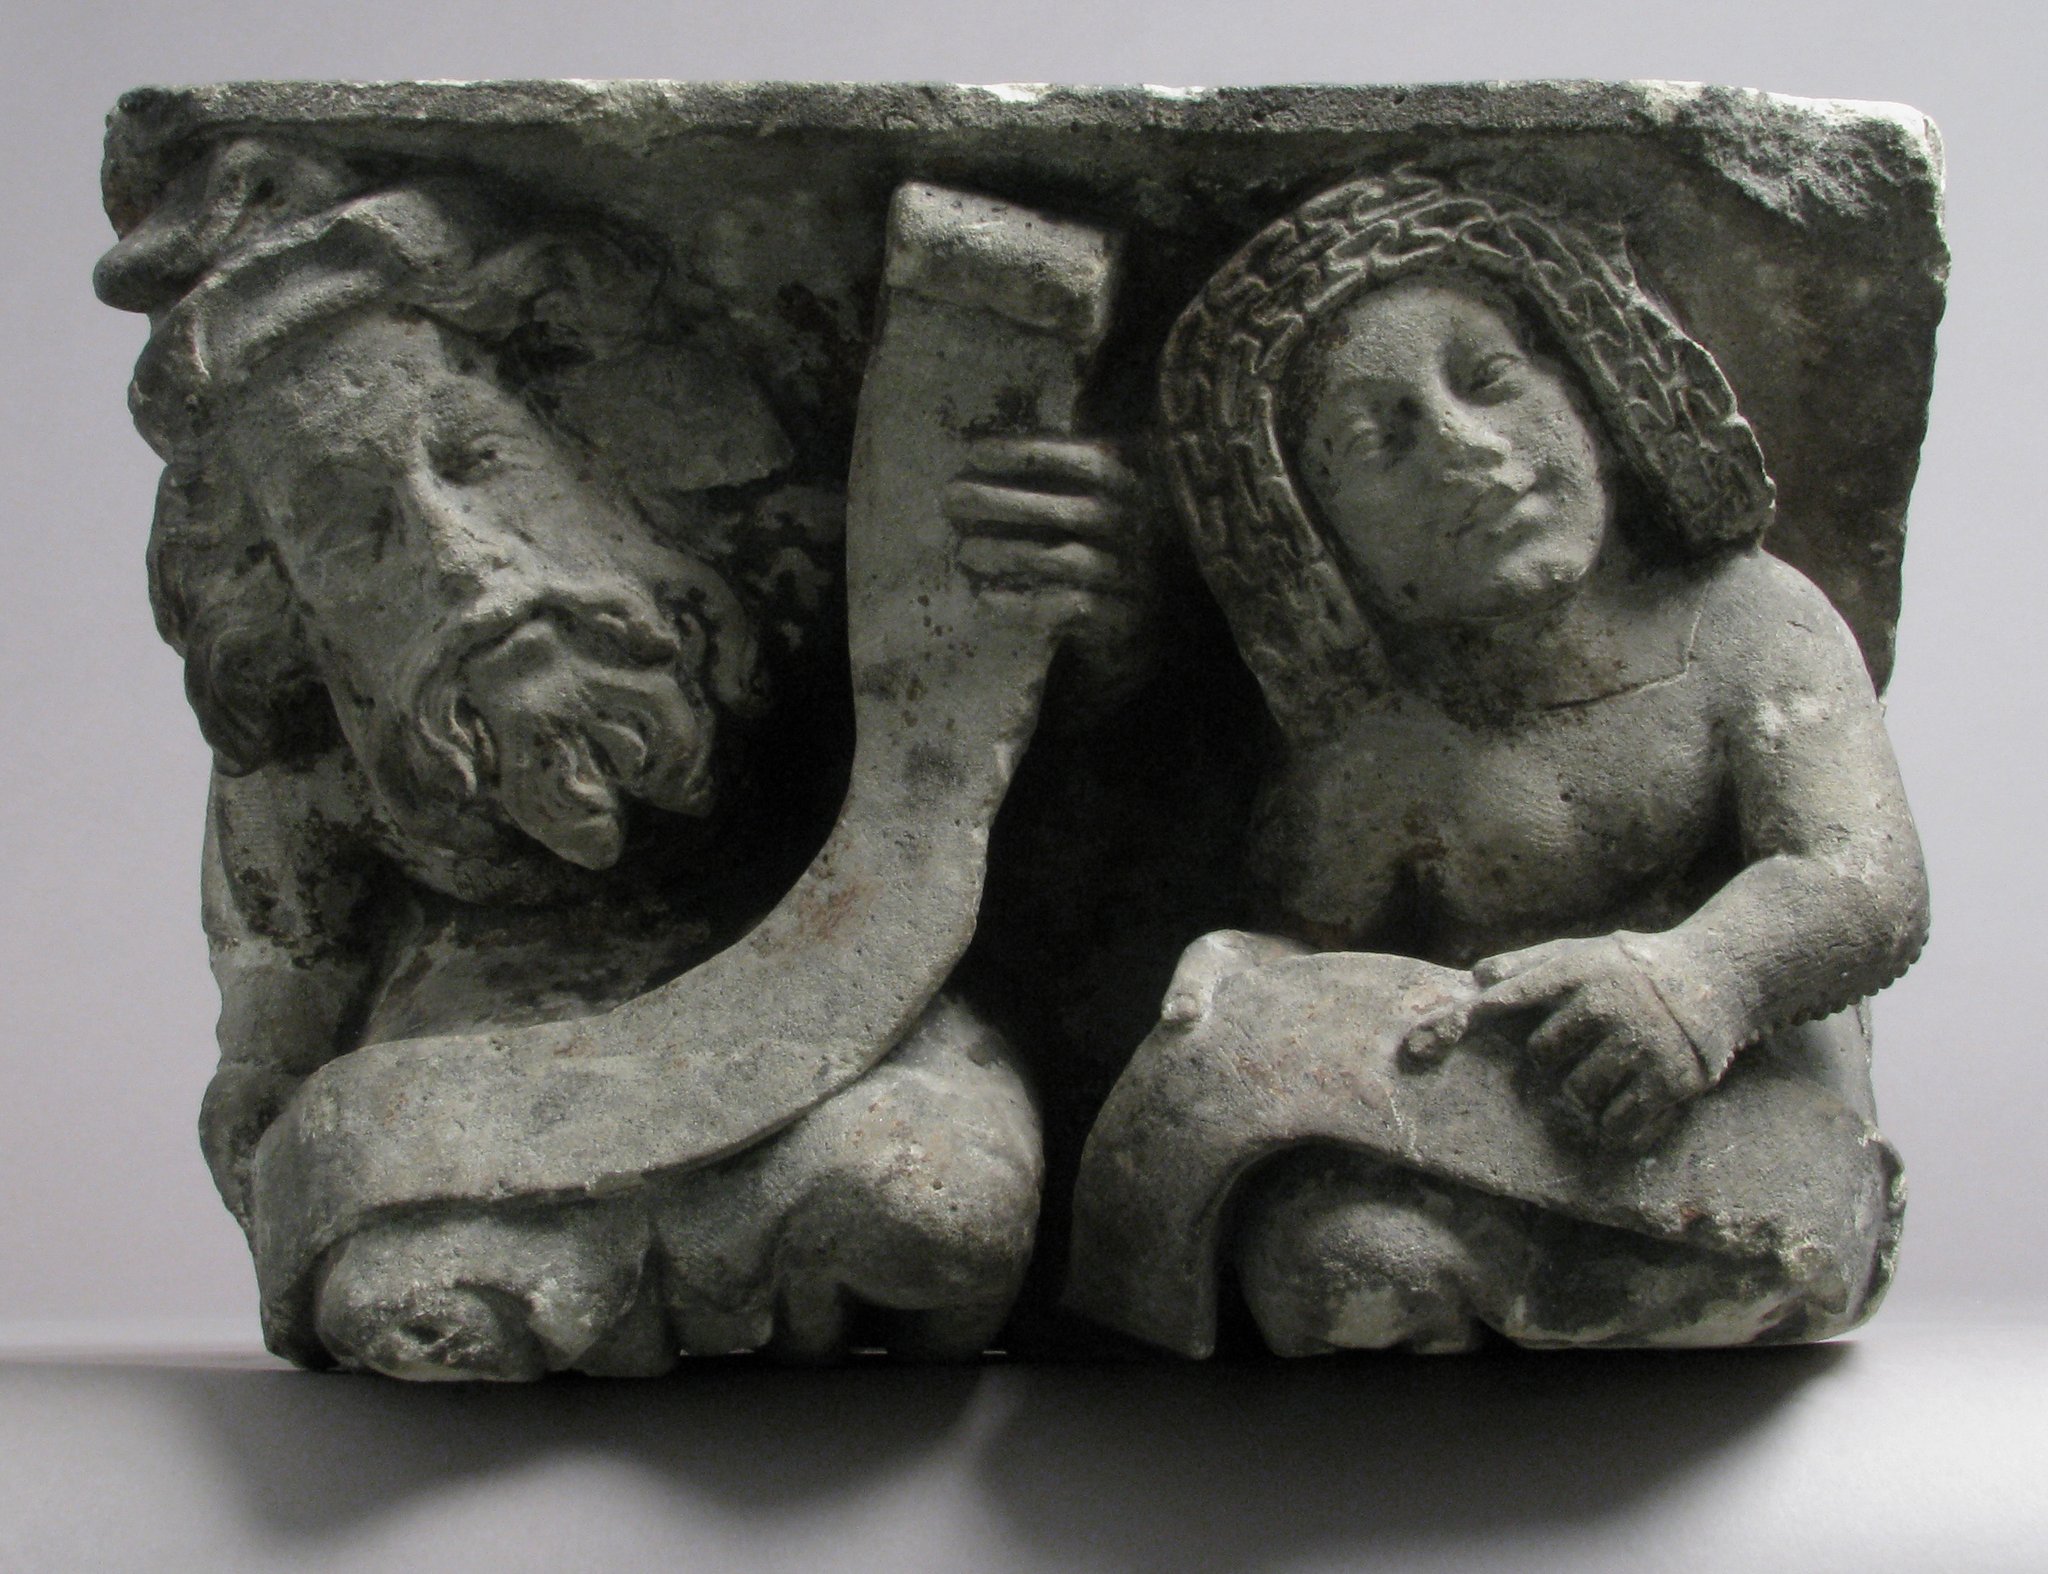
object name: corbel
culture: german or south netherlandish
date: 1401-1433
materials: limestone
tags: women